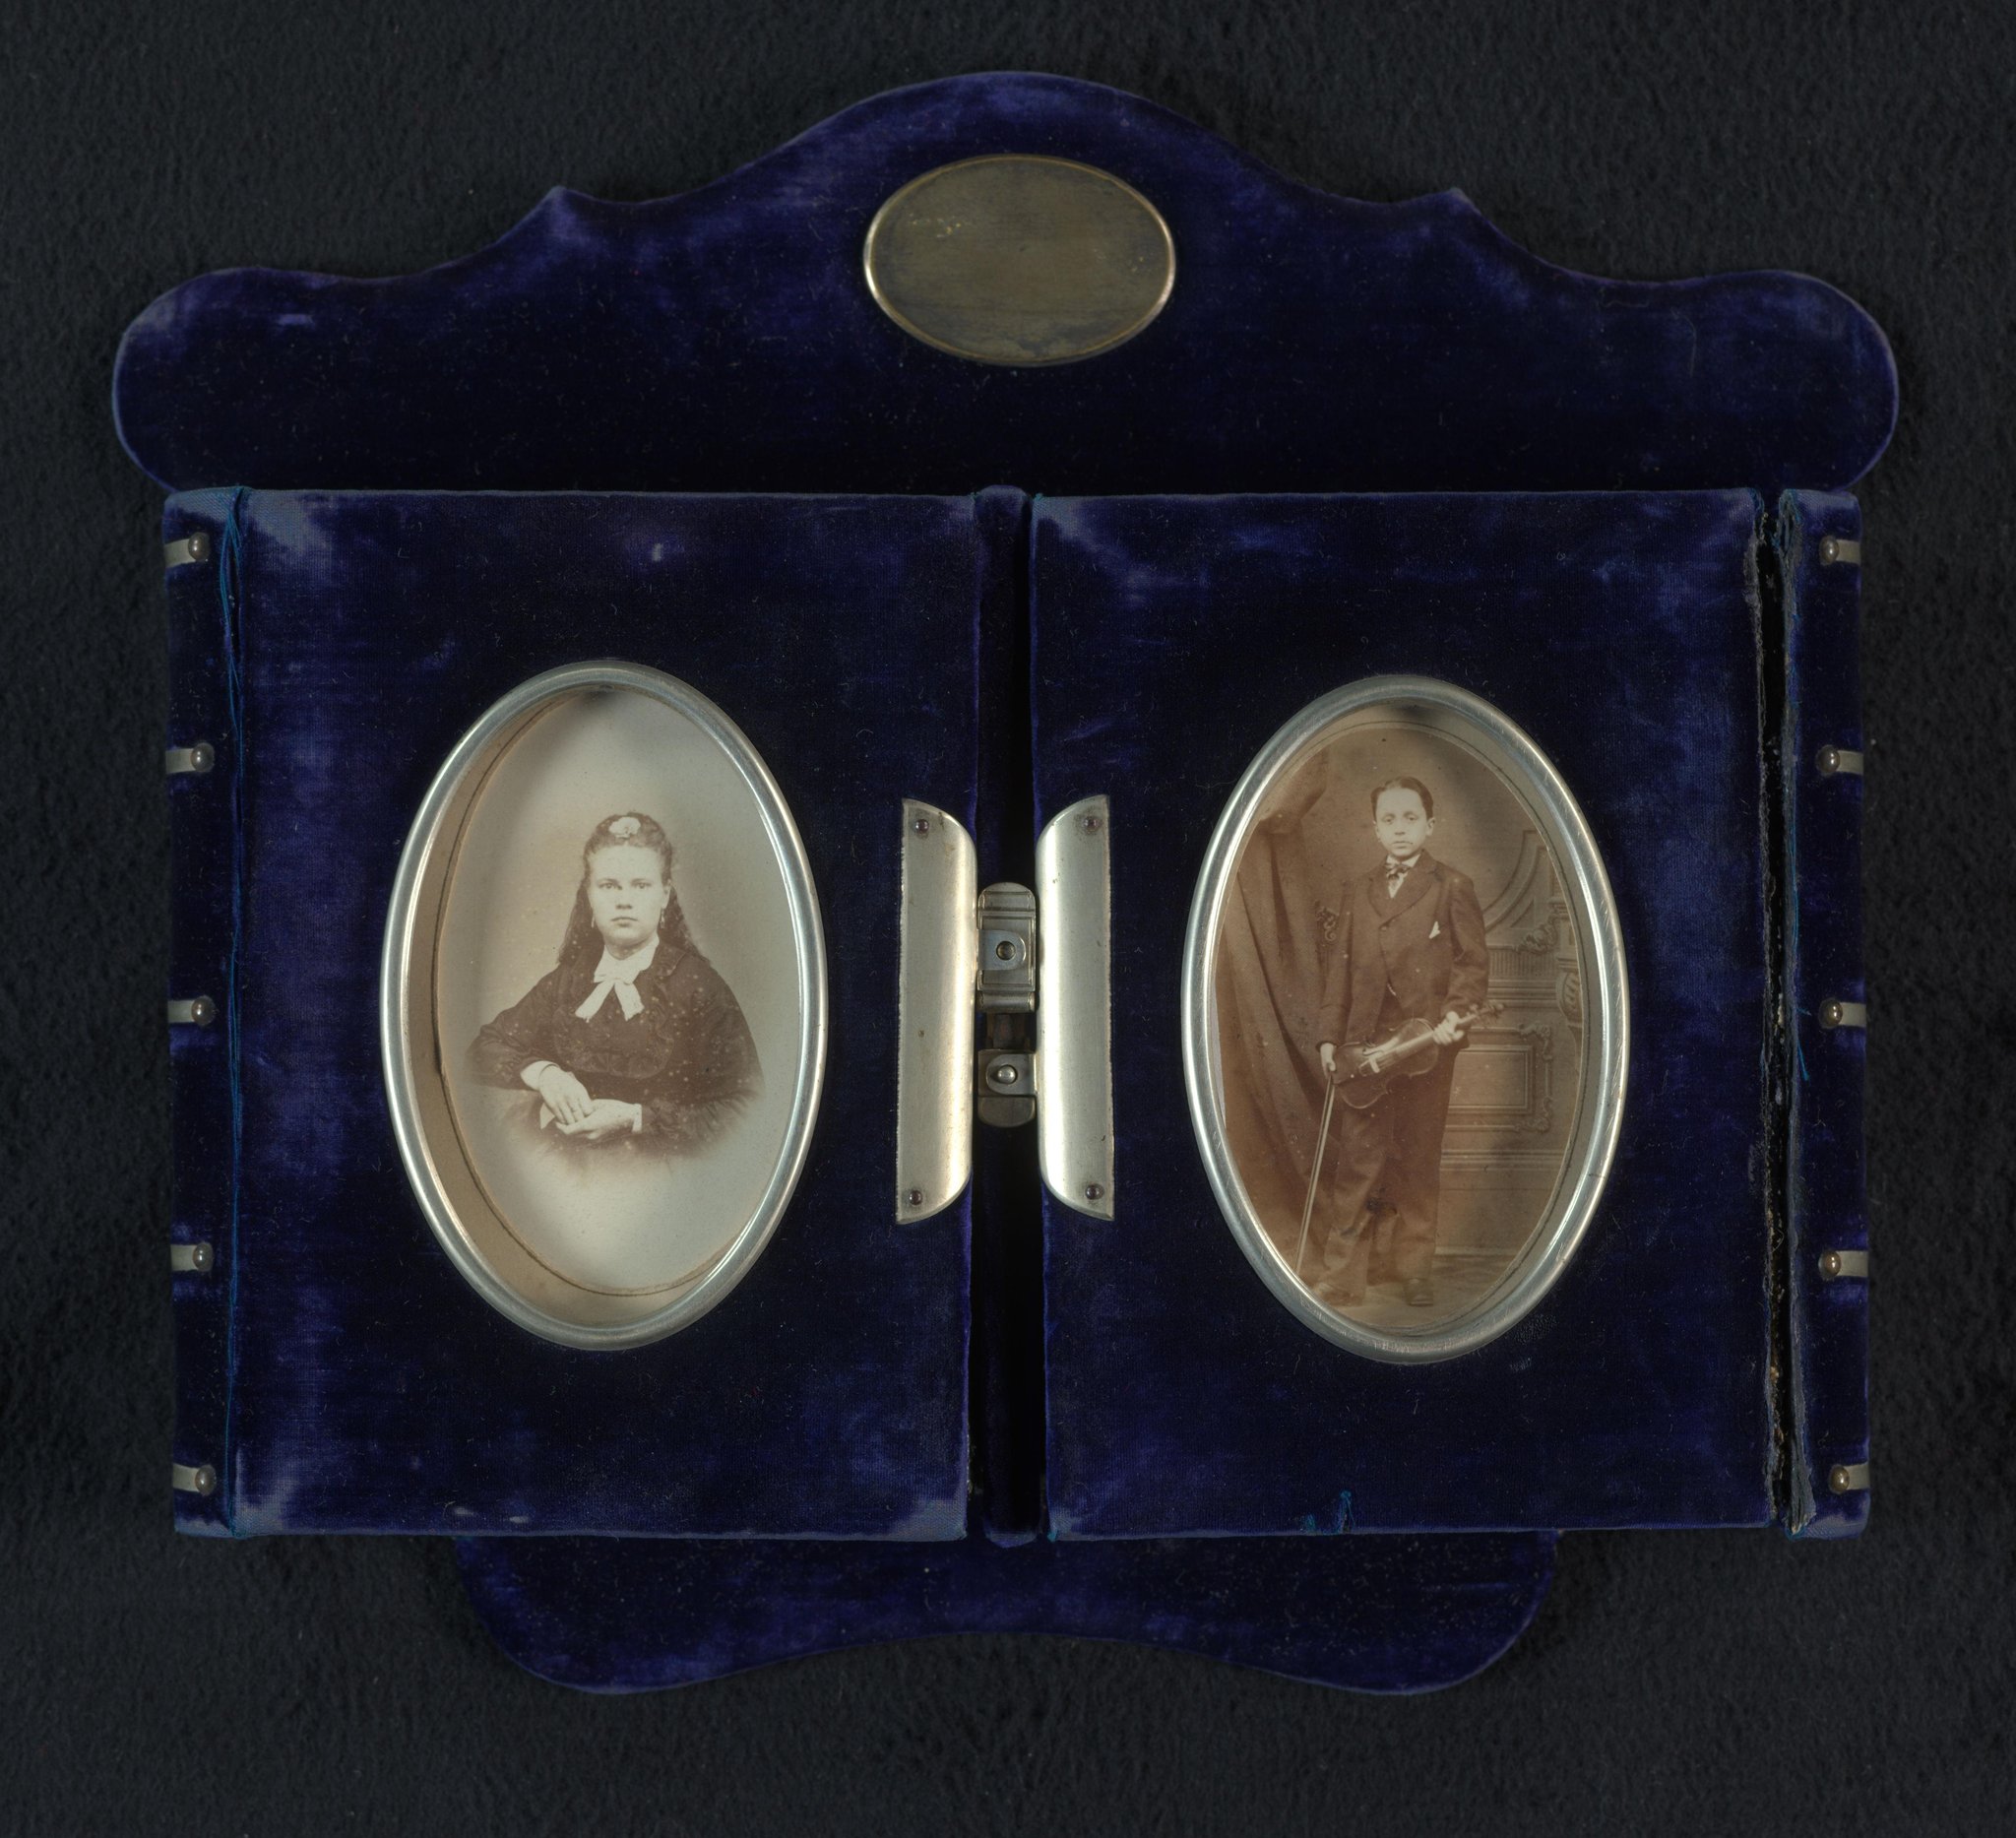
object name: accordion book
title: Nederlands familiealbum met 46 foto's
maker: Anonymous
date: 1860-1900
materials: cardboard, metal, paper, photographic support, silk, velvet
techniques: albumen print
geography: netherlands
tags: historical persons - bb - woman, child, historical persons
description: Fotoalbum met in totaal 46 foto's, verdeeld over twee leporello's die naast elkaar op een achterplat zijn bevestigd, met ieder een eigen voorplat. Iedere leporello bevat 23 cartes-de-visite in met gouden lijnen omkaderde passe-partouts. Afgebeeld zijn portretten van onbekende mannen, vrouwen en kinderen. De foto's zijn gemaakt door verschillende Nederlandse fotografen, waaronder Ed. Radermacher en Bernardus Theodorus van Loo. Van 3 foto's is de fotograaf anoniem.